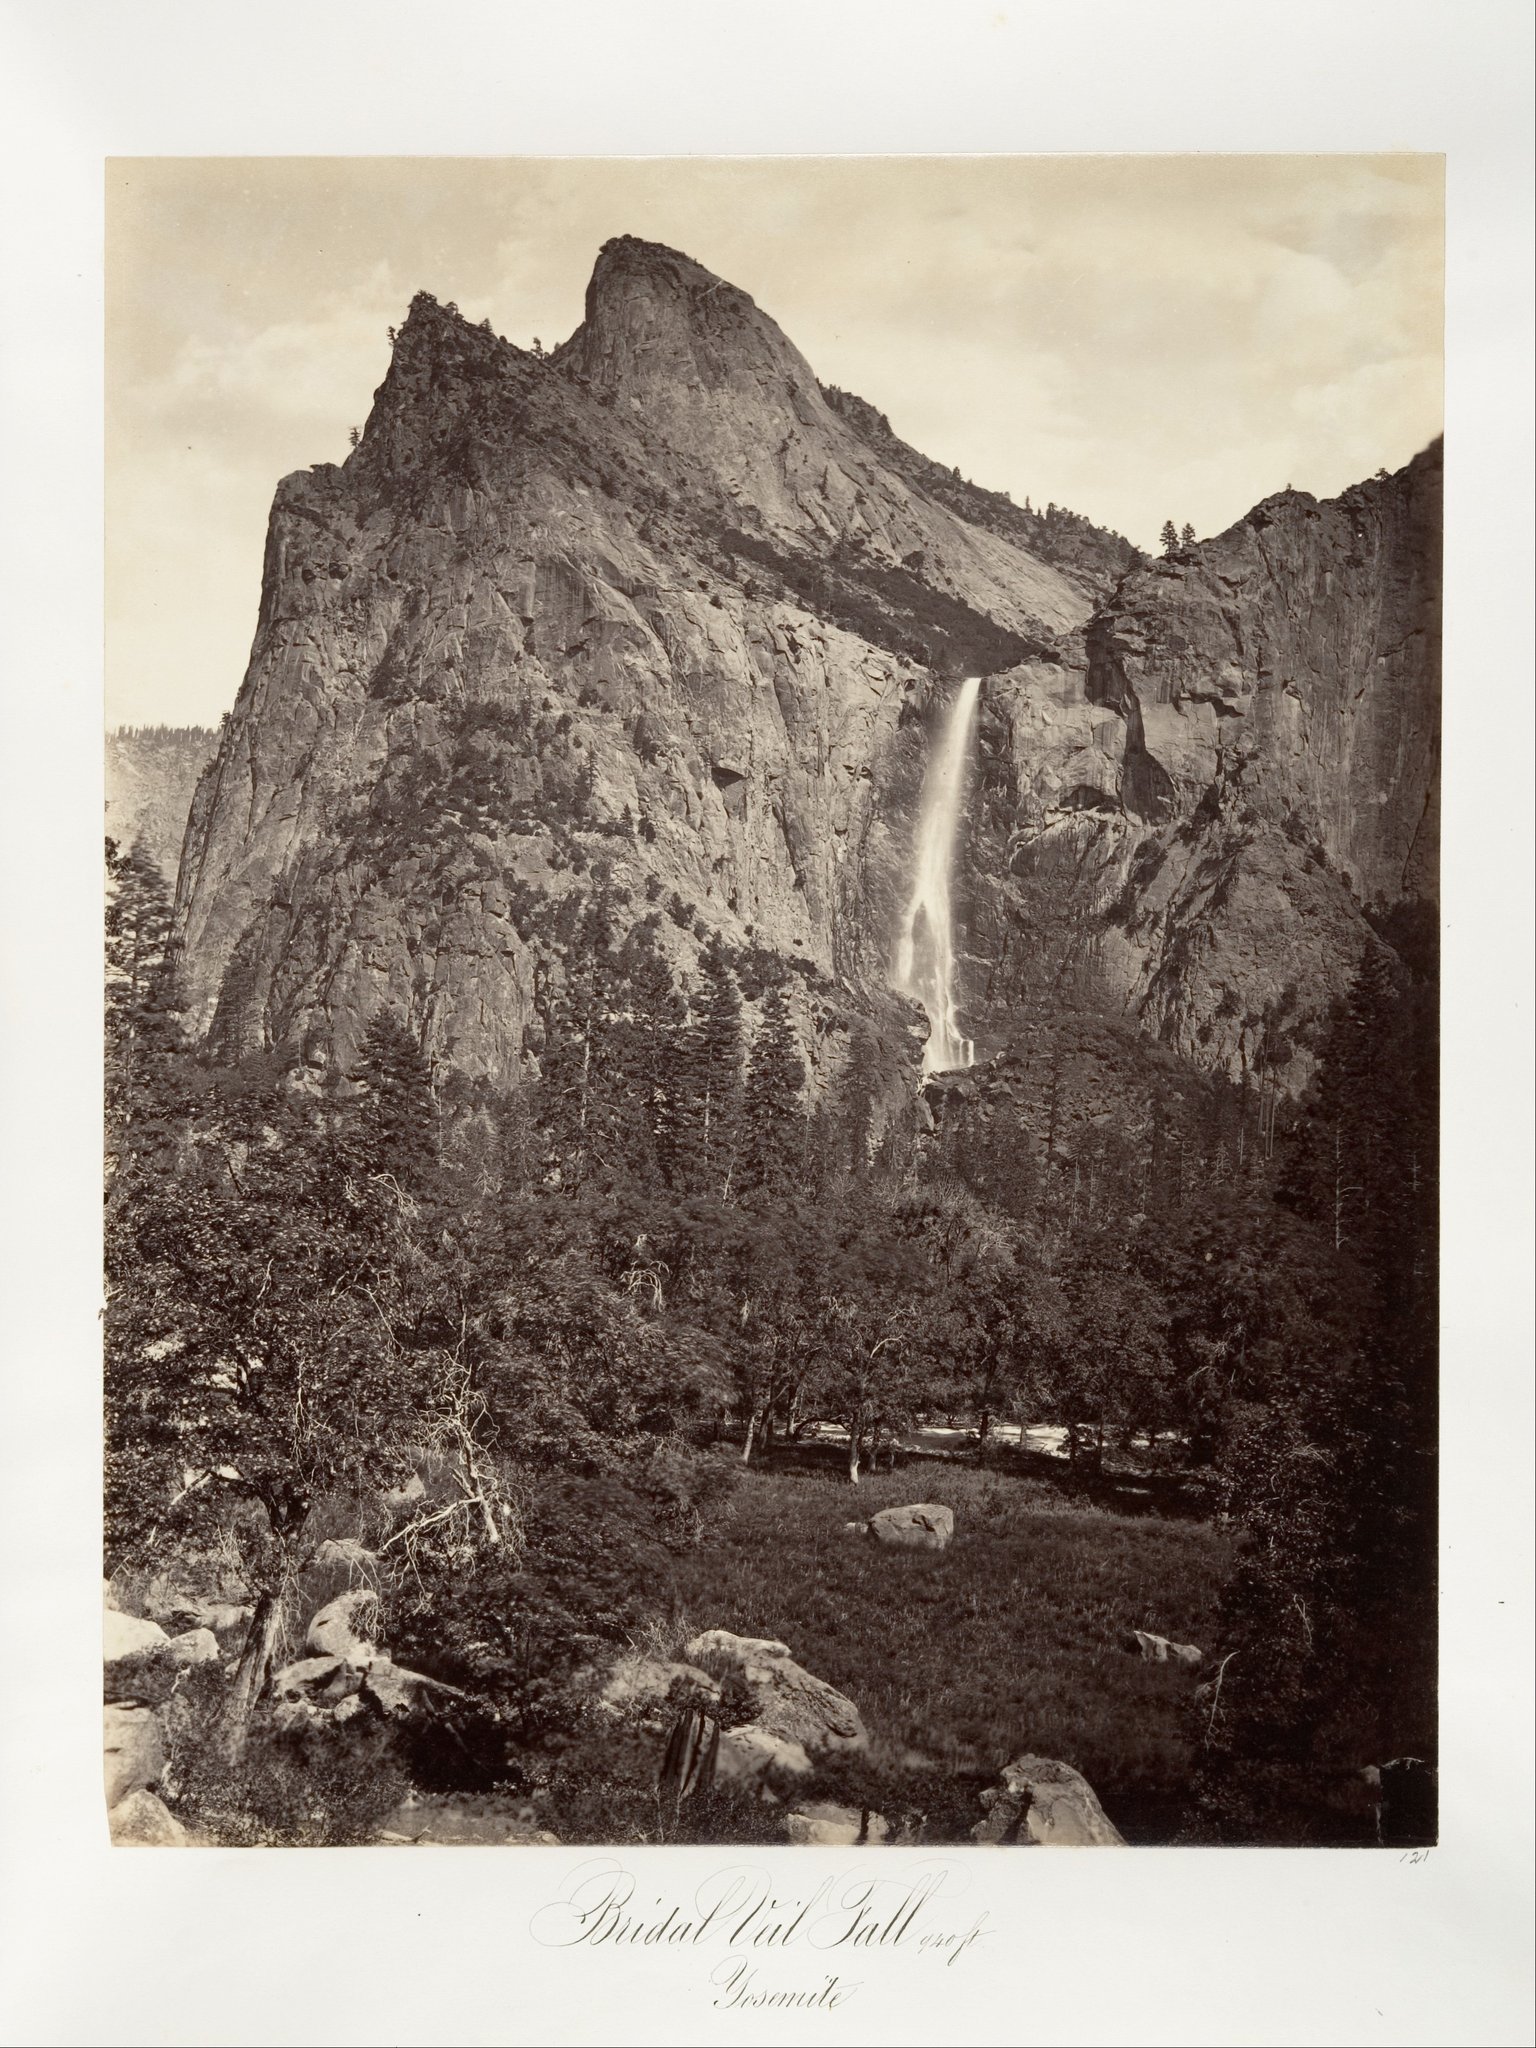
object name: photograph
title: Bridal Veil Fall, 940 feet, Yosemite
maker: carleton e. watkins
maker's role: artist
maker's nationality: american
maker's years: 1829-1916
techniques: albumen silver print, glass negative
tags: waterfalls,mountains,landscapes